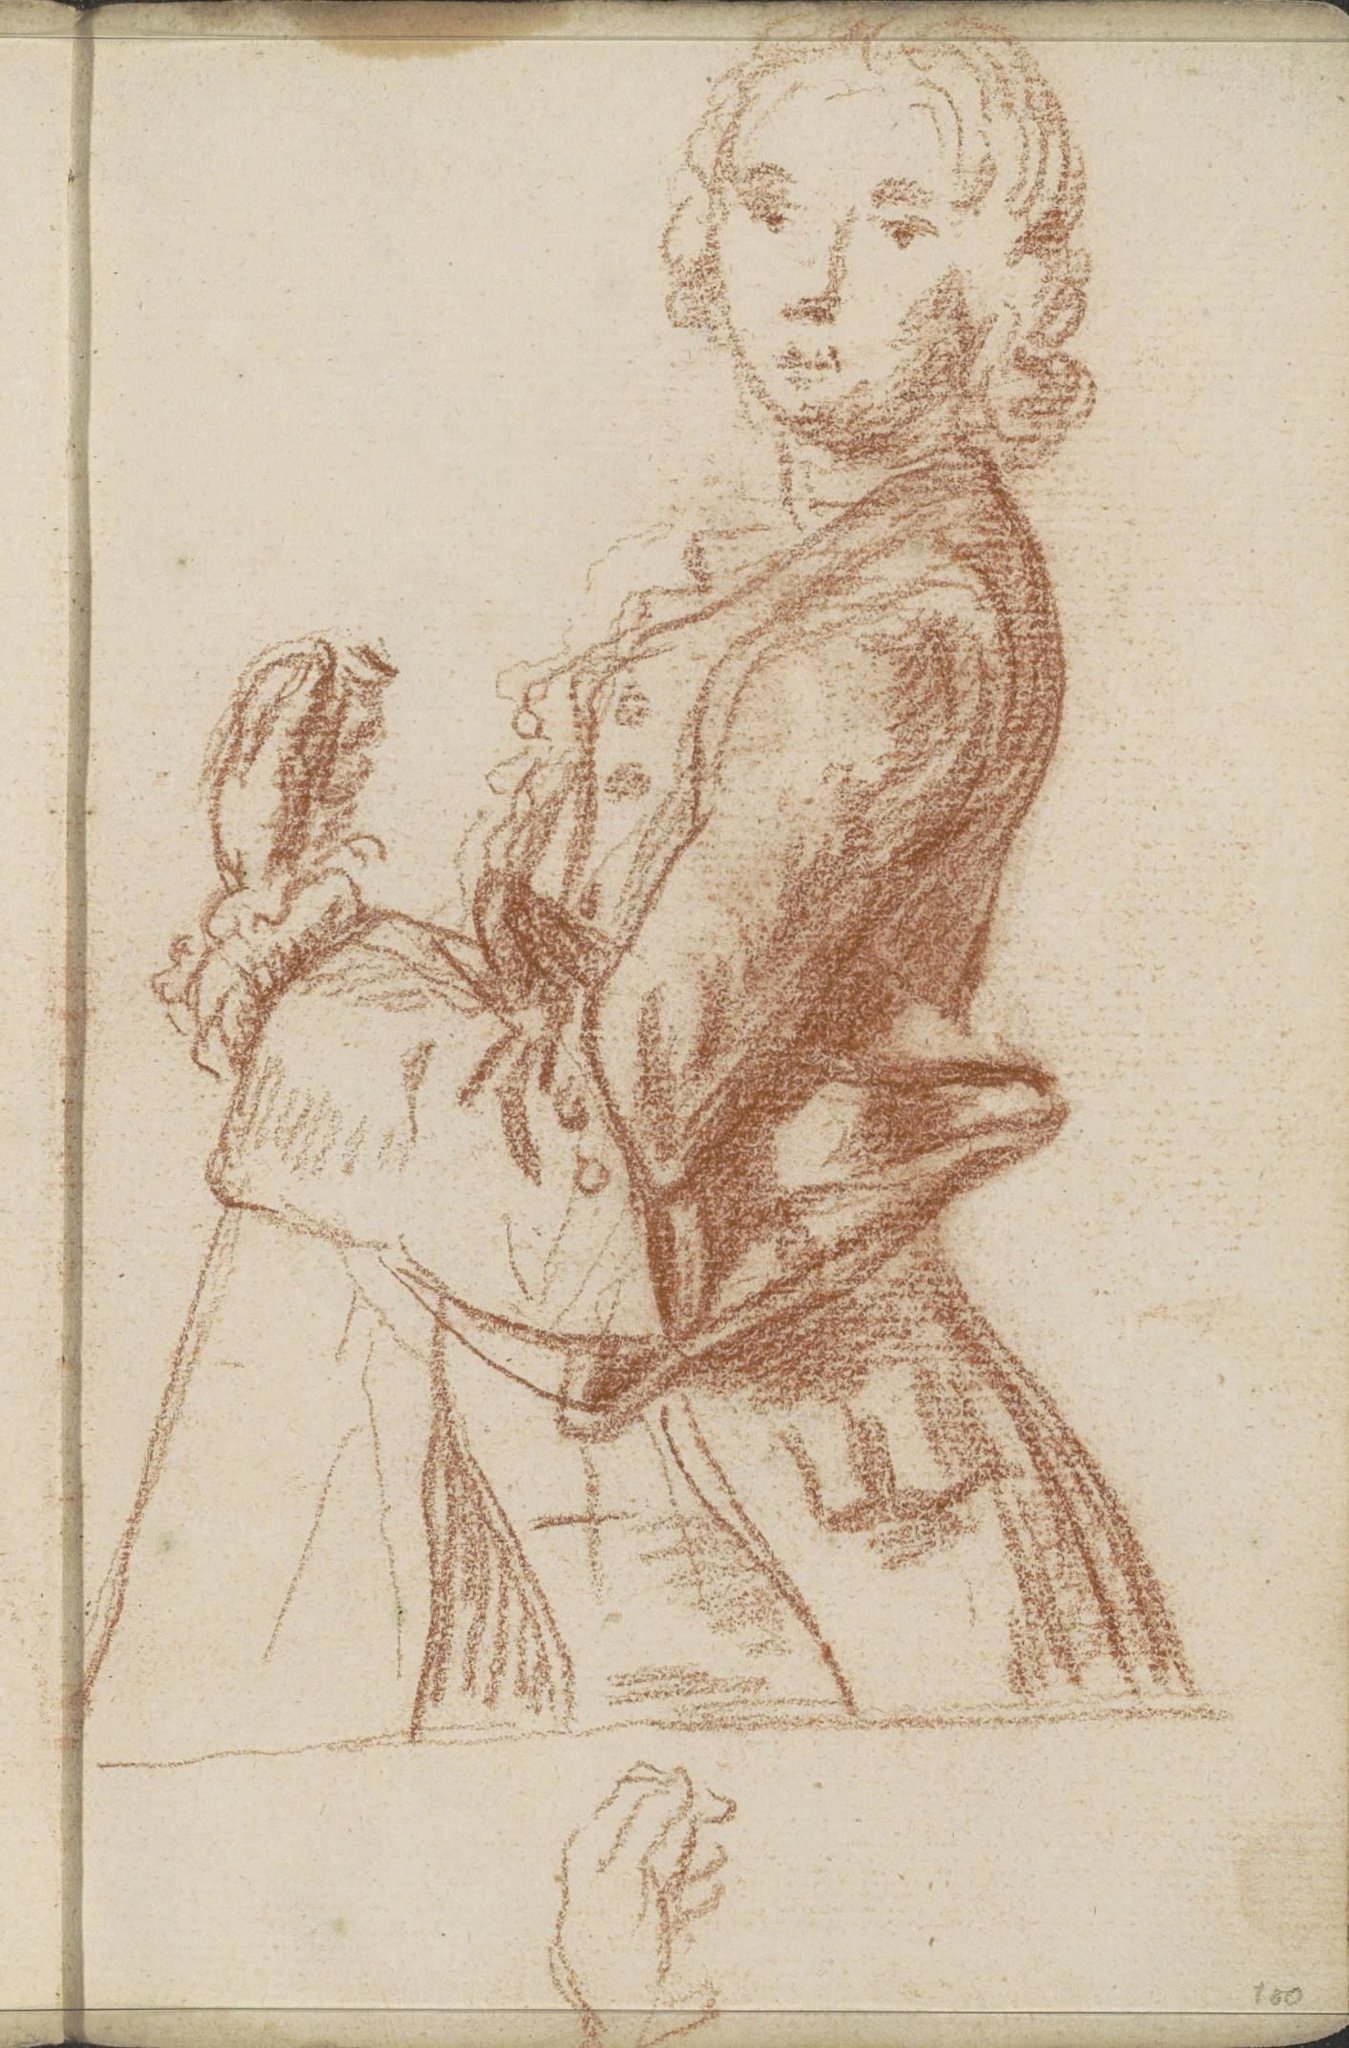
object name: sketchbook leaf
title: Staande man met opgeheven hand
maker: petrus johannes van reysschoot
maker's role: draughtsman, print maker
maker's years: 1702-1772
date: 1710-1772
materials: chalk, paper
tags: standing figure, arm stretched forward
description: Blad 100 recto uit een schetsboek met 105 bladen.